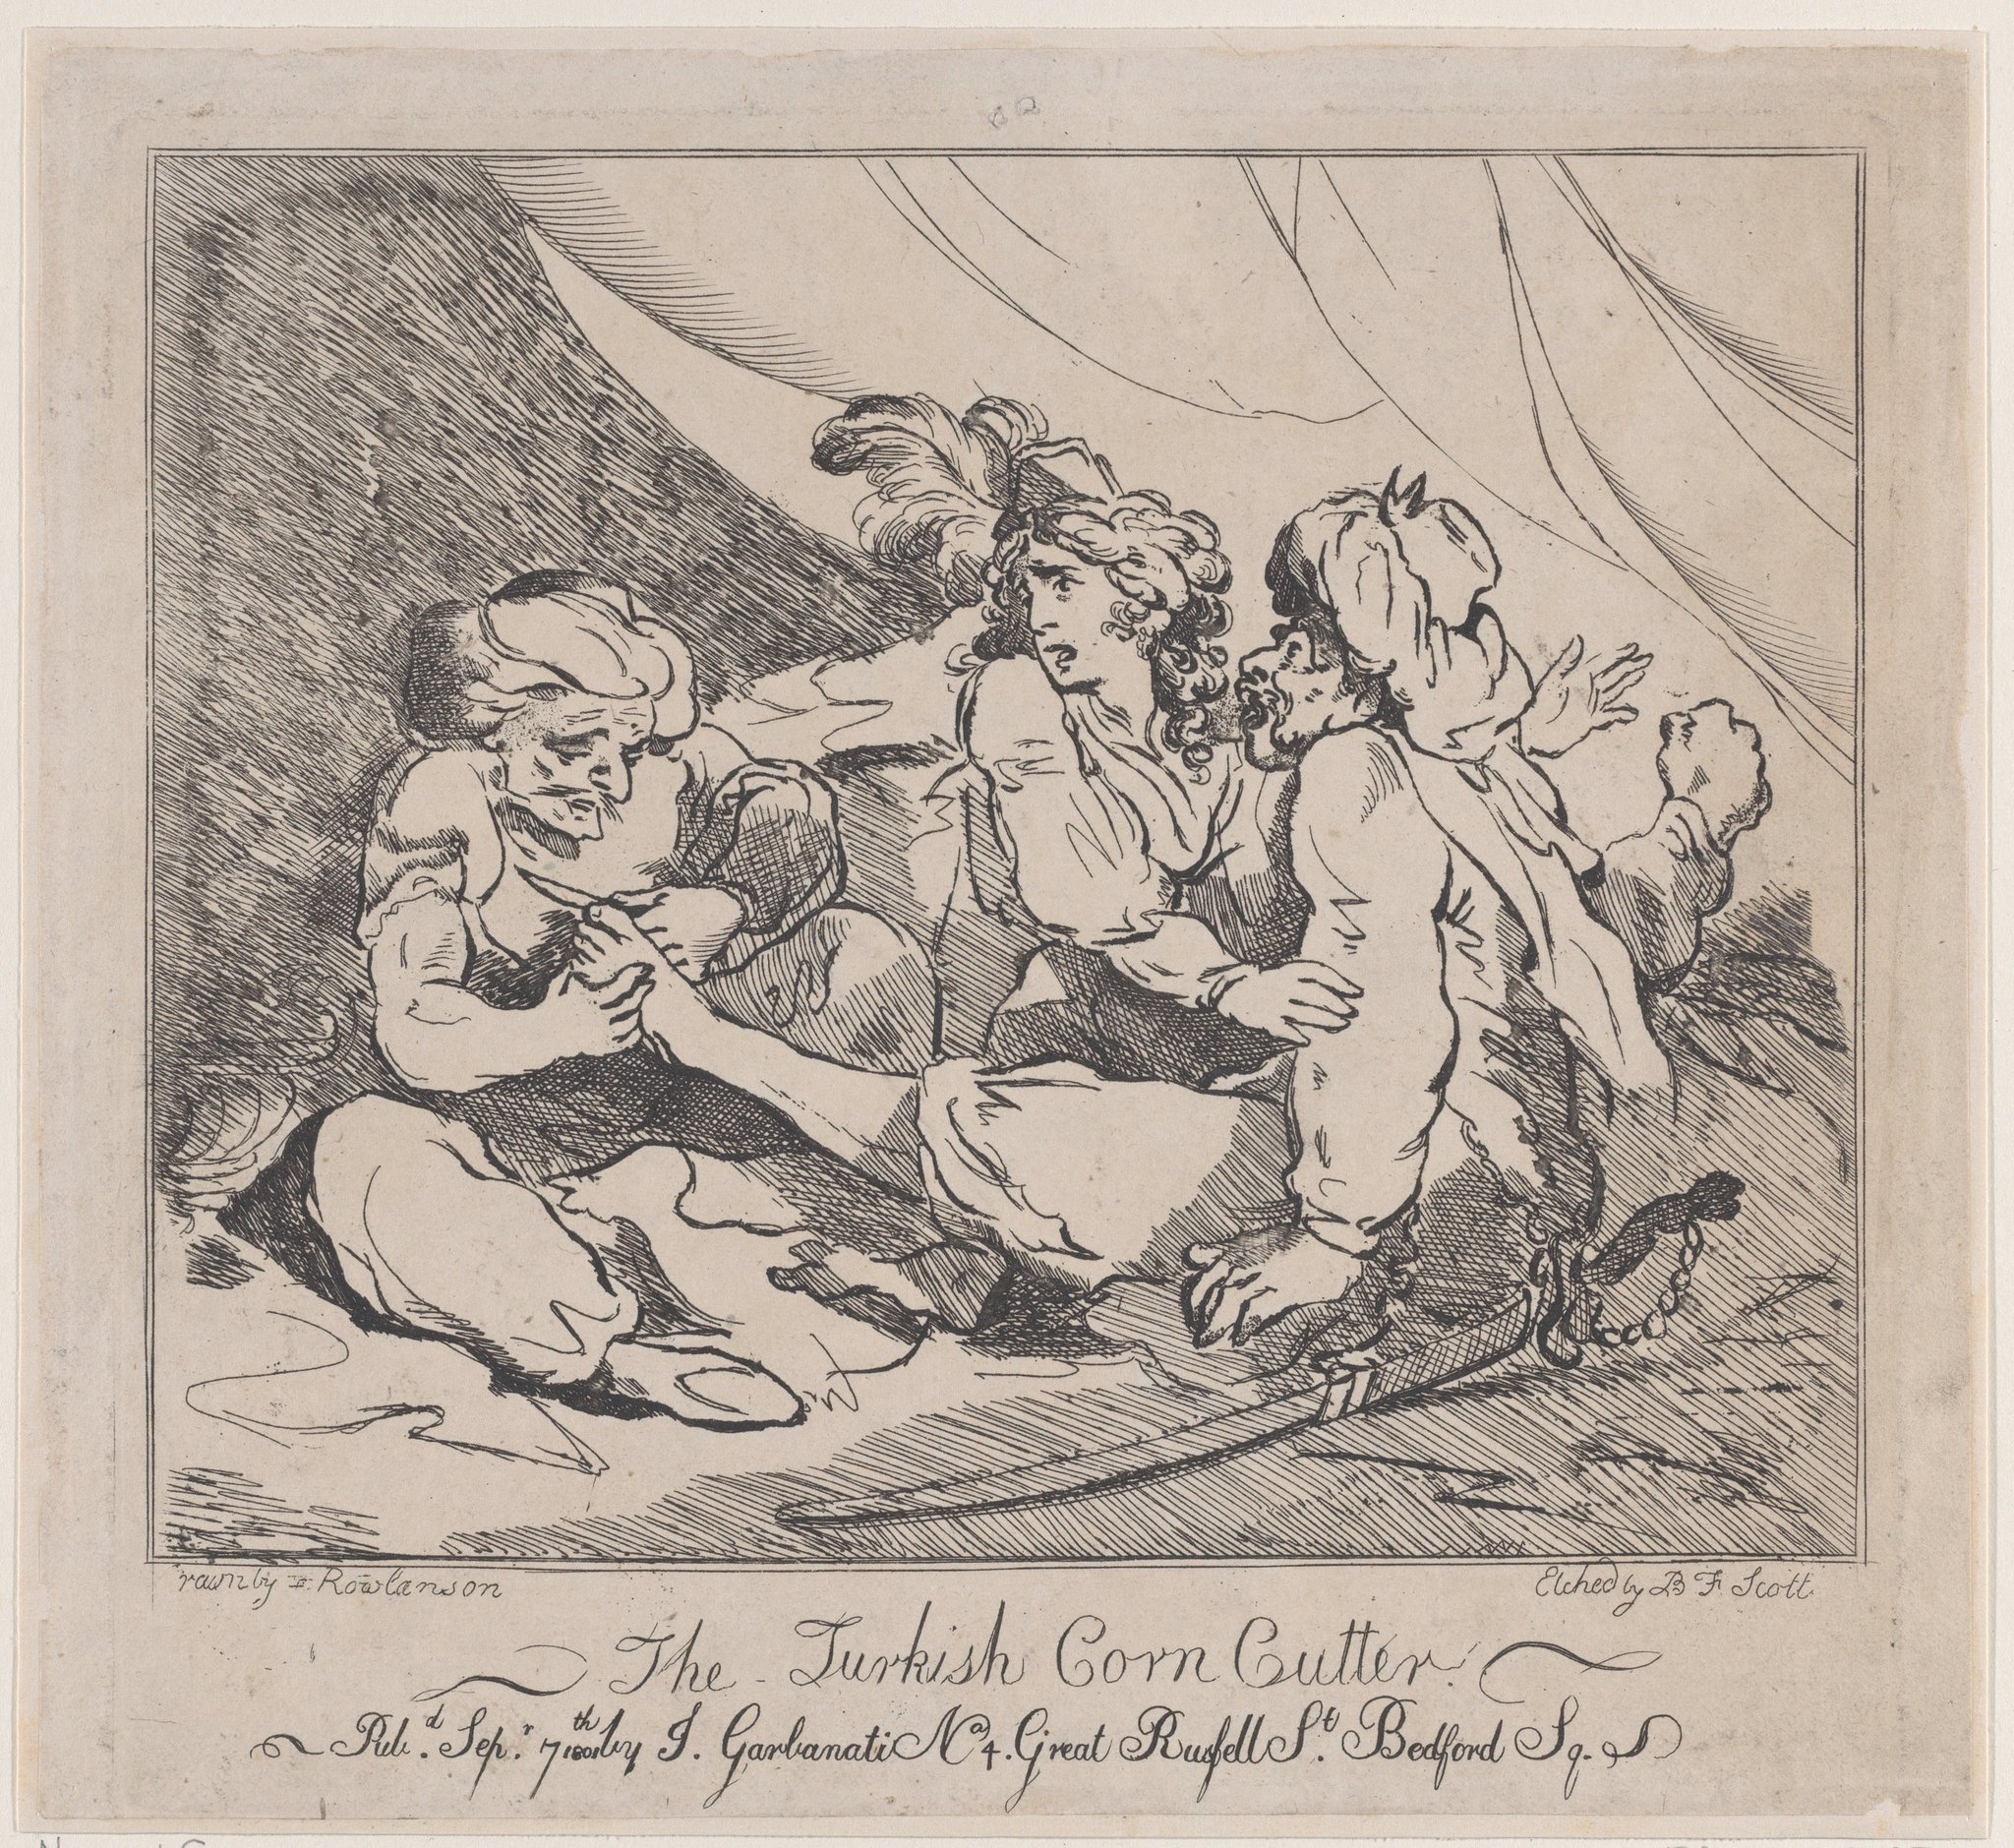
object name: print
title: The Turkish Corn Cutter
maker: b.f. scott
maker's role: artist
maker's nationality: british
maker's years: 1750-1850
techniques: etching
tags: men,women